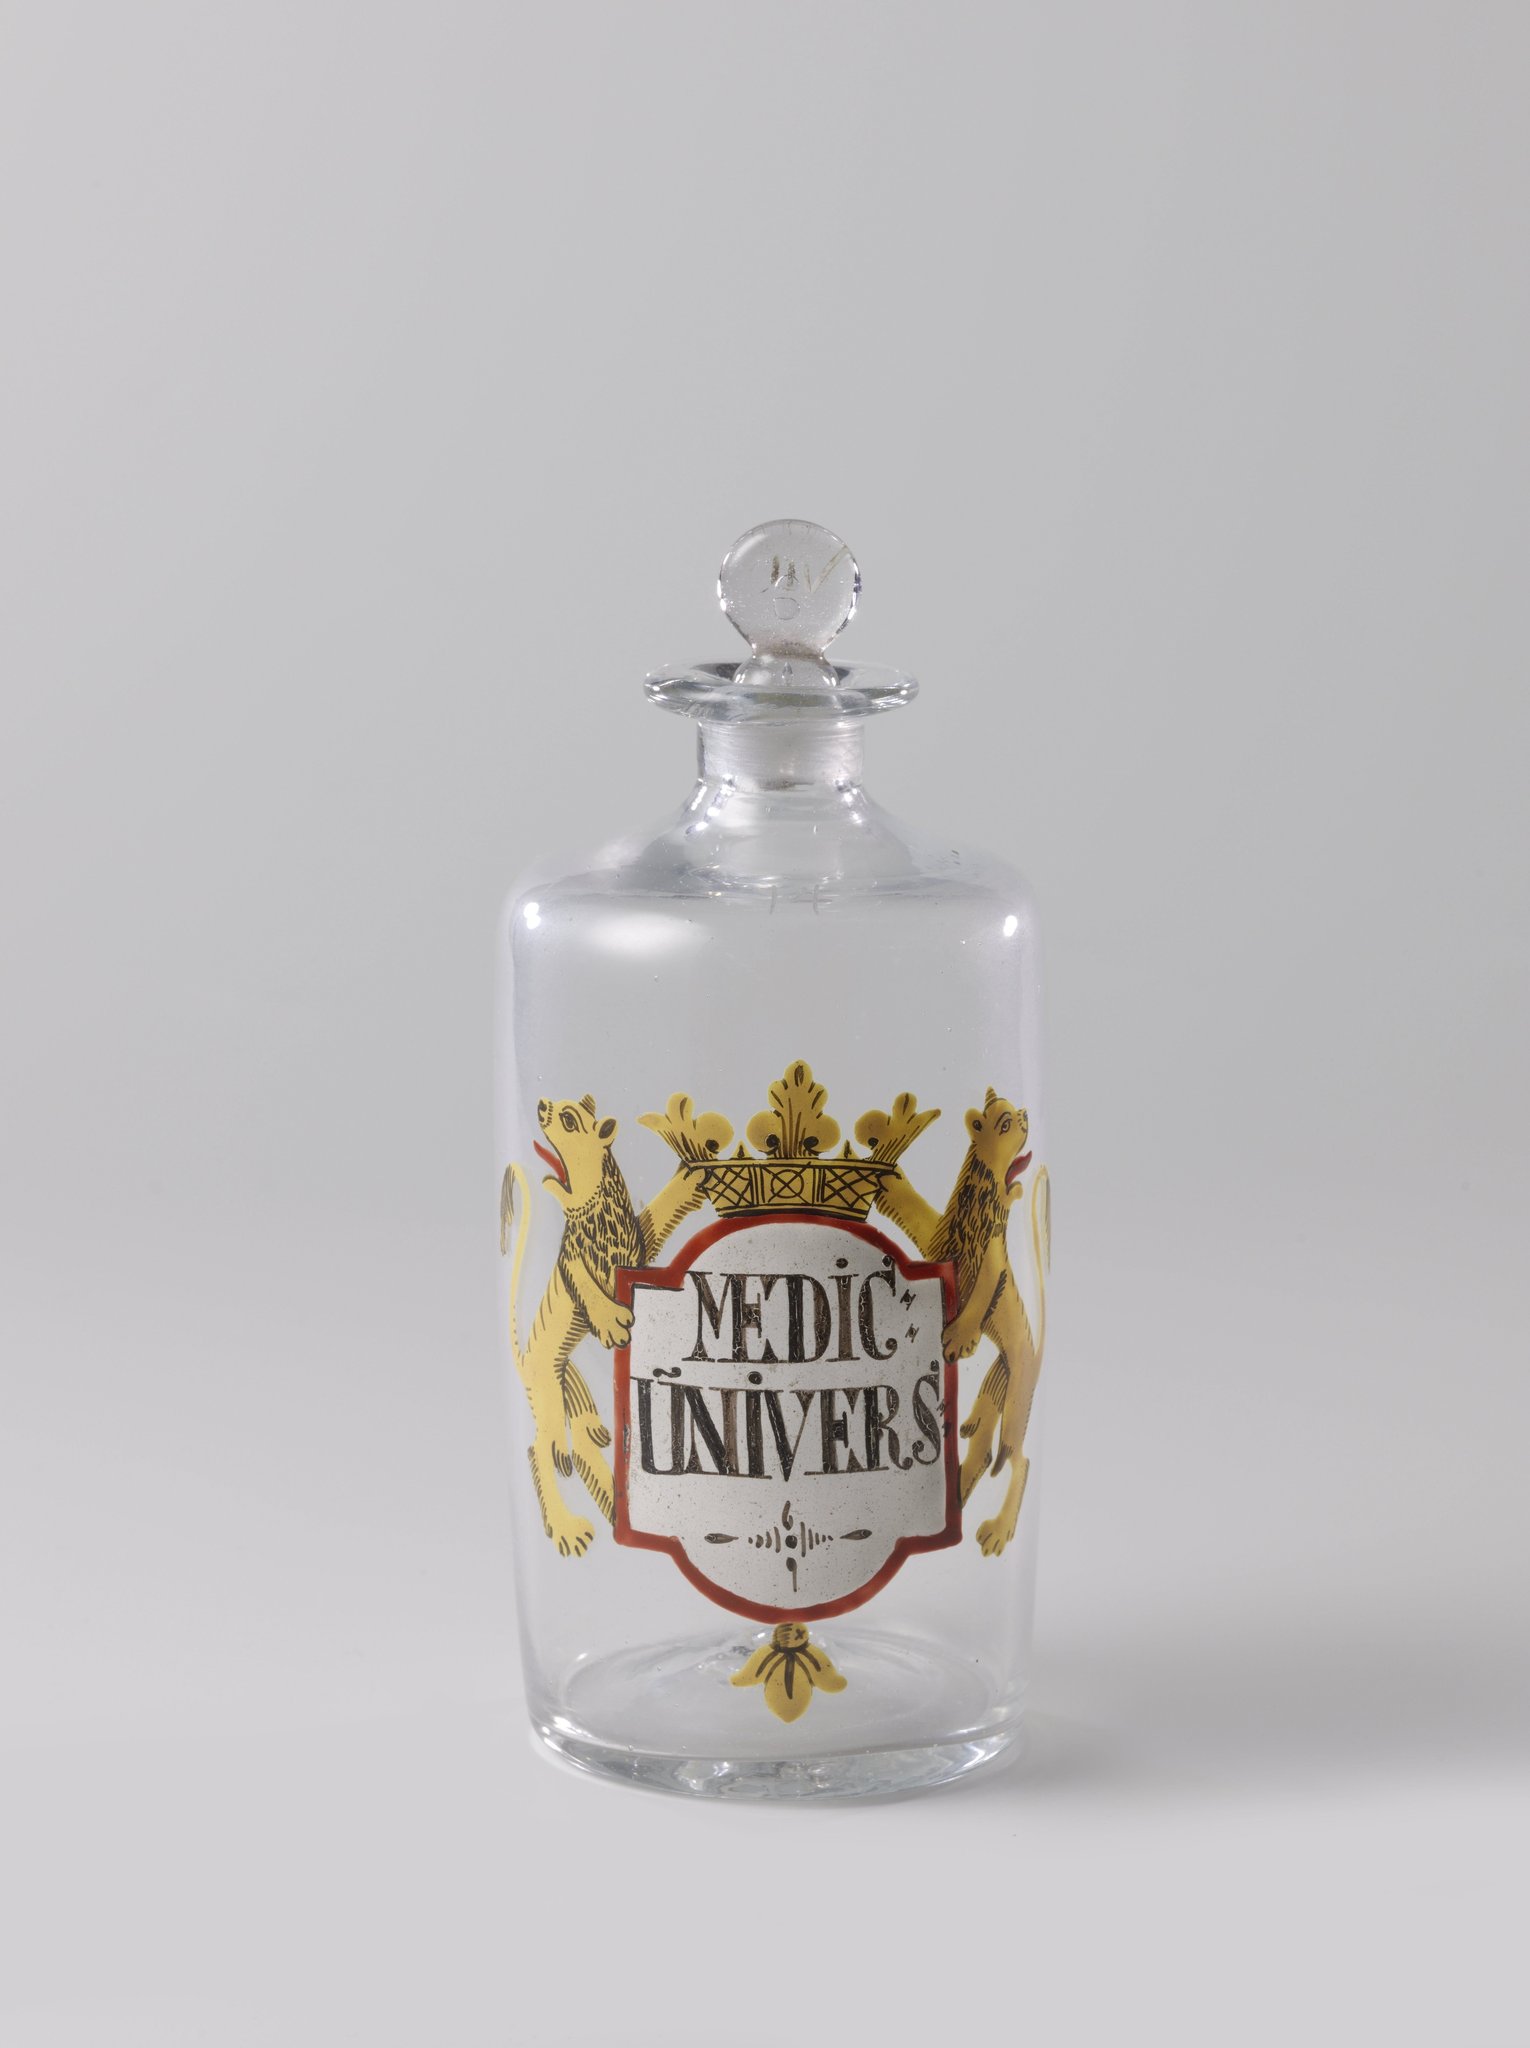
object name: apothecary bottle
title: Apothekersfles met stop, met het opschrift: MEDIC: ÜNIVERS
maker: Anonymous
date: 1700-1800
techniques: glassblowing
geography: central europe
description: Vlakke bodem. Cylindervormig lichaam, afgeronde schouder,korte, cylindervormige hals met uitkragende rand, ingeslepen stop met platte ronde knop. Op het lichaam in wit, zwart, geel en rood een bekroonde cartouche, gehouden door twee staande leeuwen, met het opschrift MEDIC: NIVERS. Op de schouder is met het rad 14 en op de stop VII gegraveerd.